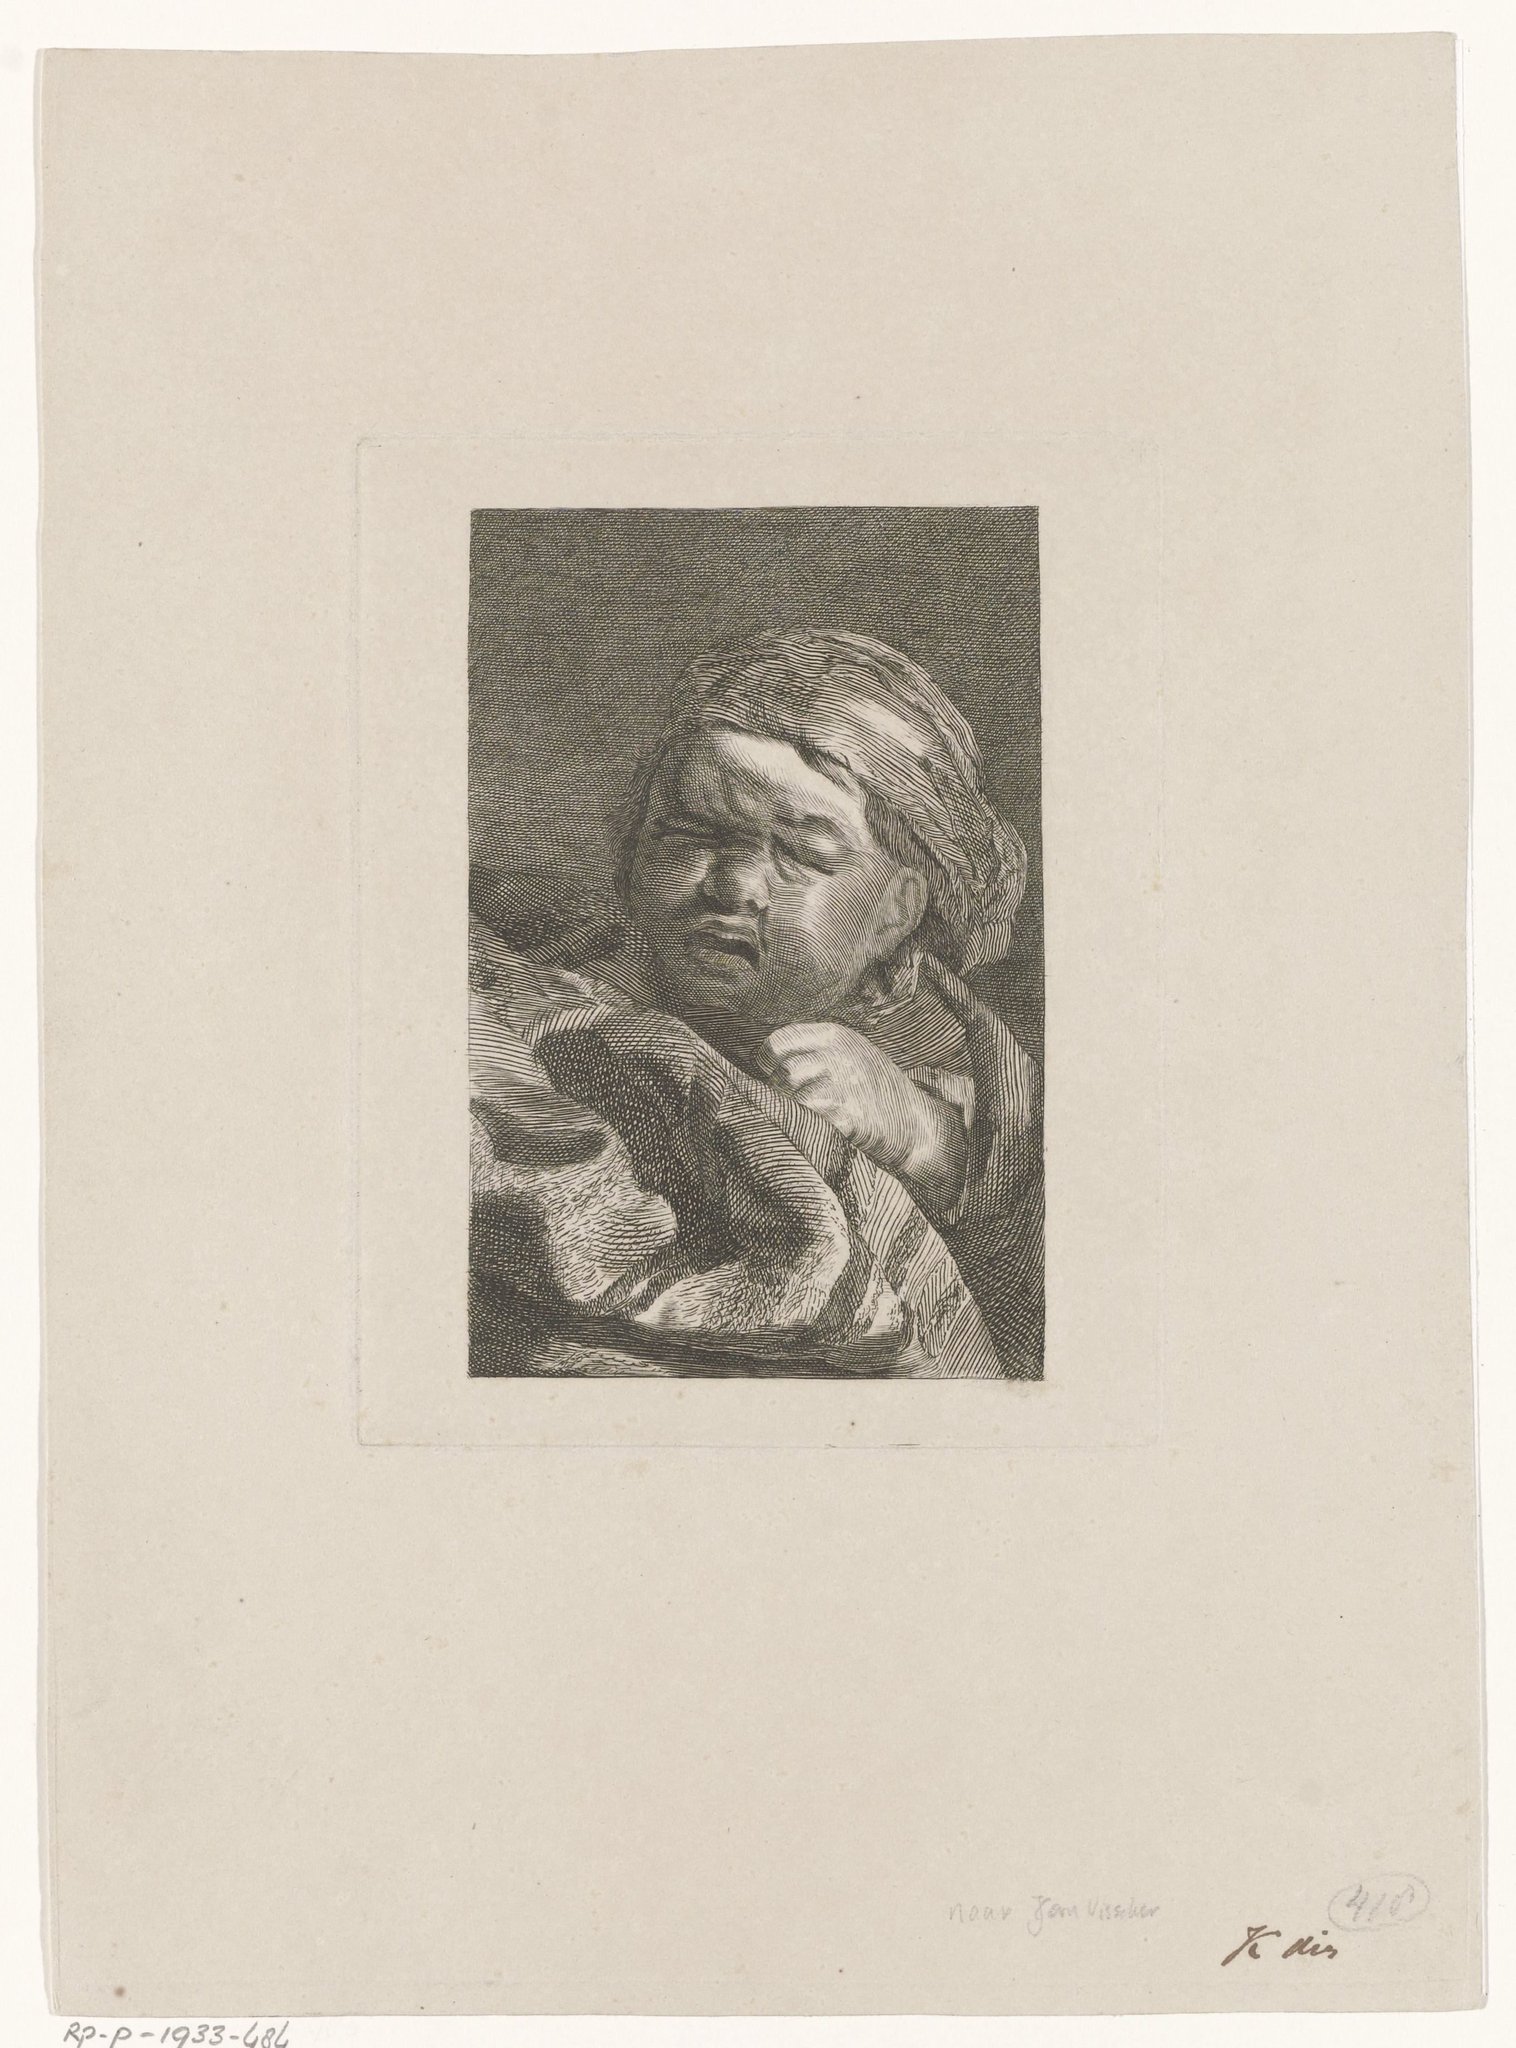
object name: print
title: Huilend kind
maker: Anonymous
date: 1800-1900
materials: paper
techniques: engraving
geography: netherlands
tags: child (+ being sad, suffering, sorrowing)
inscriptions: collector's mark: Lugt 2228